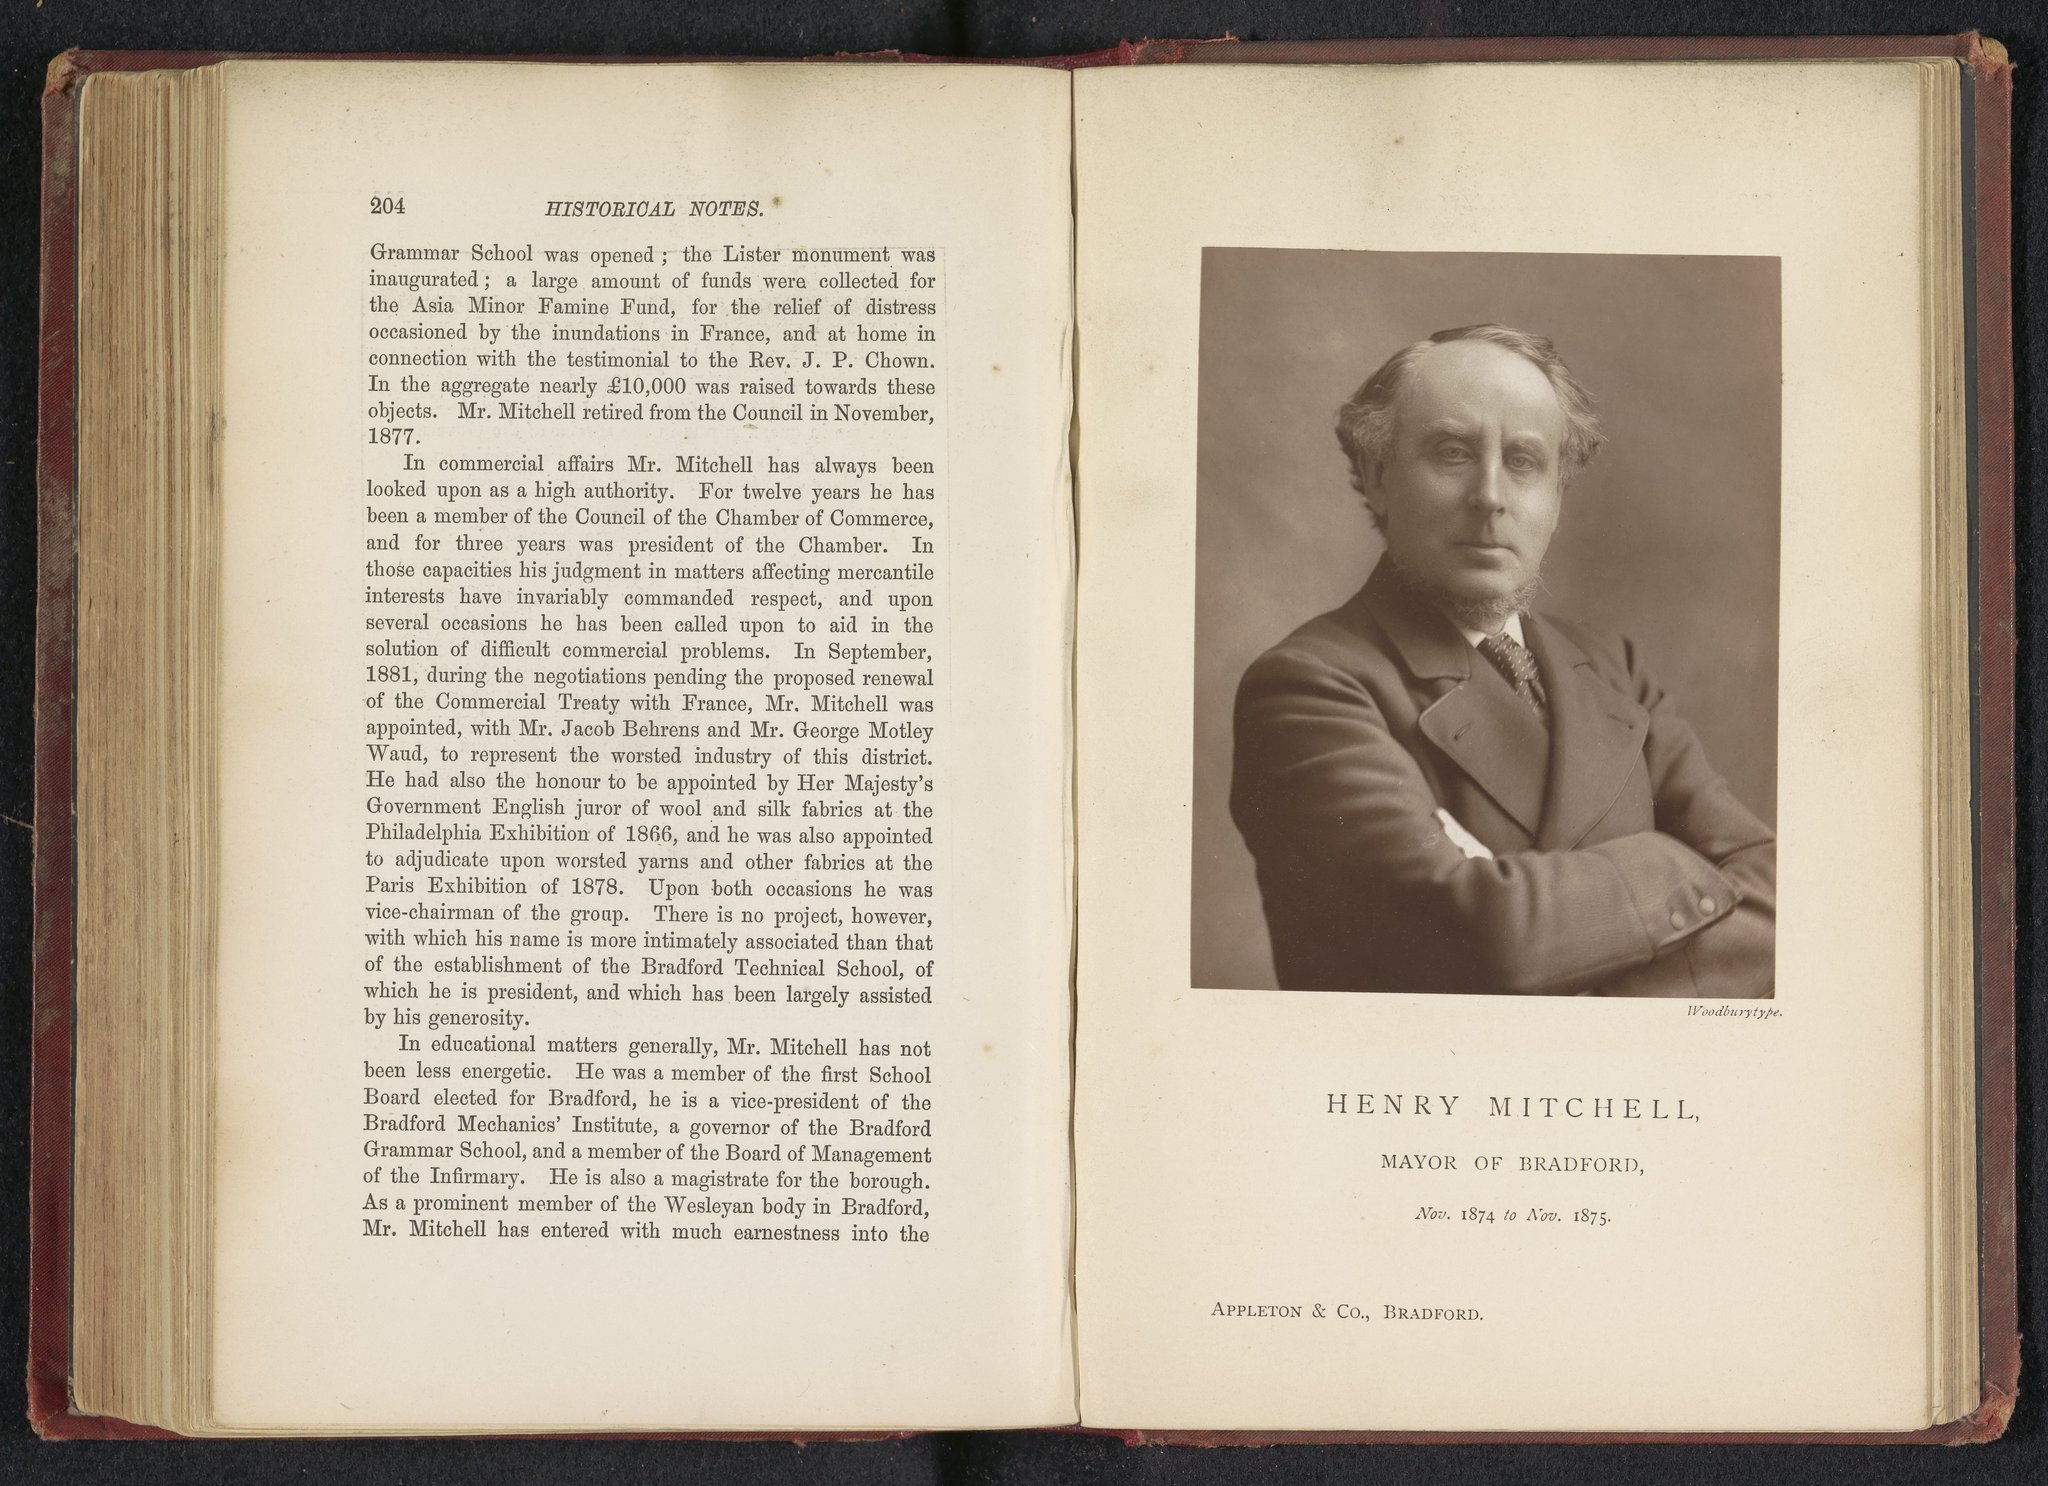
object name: photomechanical print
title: Henry Mitchell, mayor of Bradford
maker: Anonymous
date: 1871-1881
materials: paper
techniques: woodburytype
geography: bradford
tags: can hook, historical persons (portraits and scenes from the life) (+ (full) bust portrait)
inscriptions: inscription: ‘Nov. 1874 to Nov. 1875.’